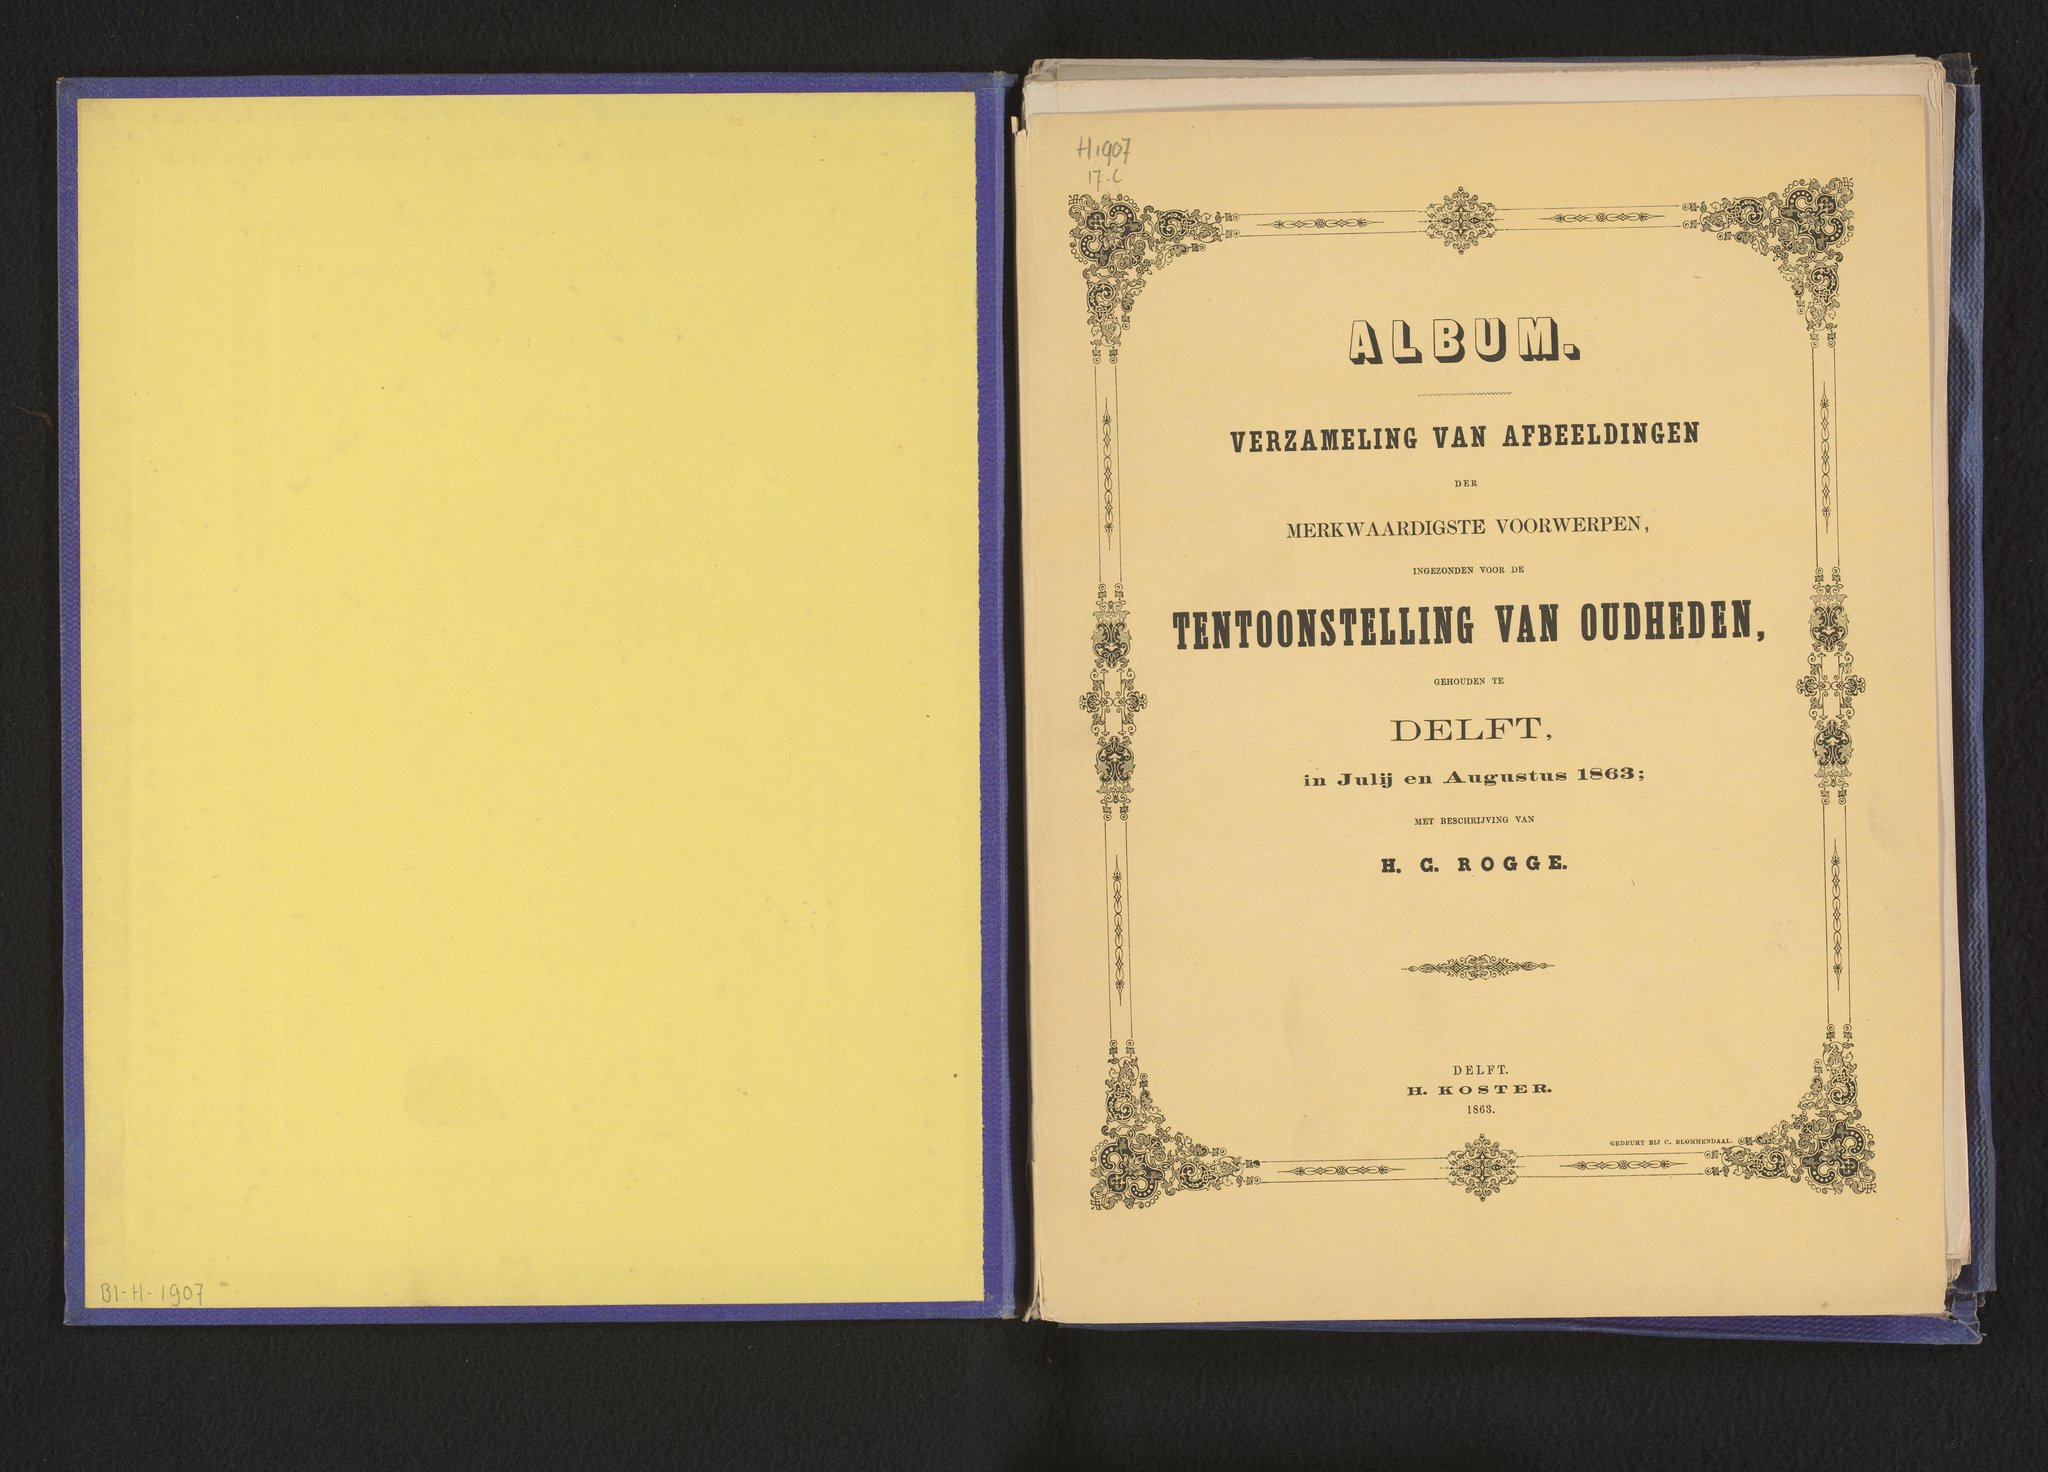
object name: wrapper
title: Album : verzameling van afbeeldingen der merkwaardigste voorwerpen, ingezonden voor de tentoonstelling van oudheden, gehouden te Delft, in Julij en Augustus 1863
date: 1863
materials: cardboard, linen, paper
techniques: albumen print, letterpress printing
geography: delft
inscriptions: inscription: ‘75-’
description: Omslag voor zestien bladen met foto's en toonlithografieën van voorwerpen op de Tentoonstelling van oudheden in Delft in 1863 en een gebonden boek met een beschrijving van ieder blad.